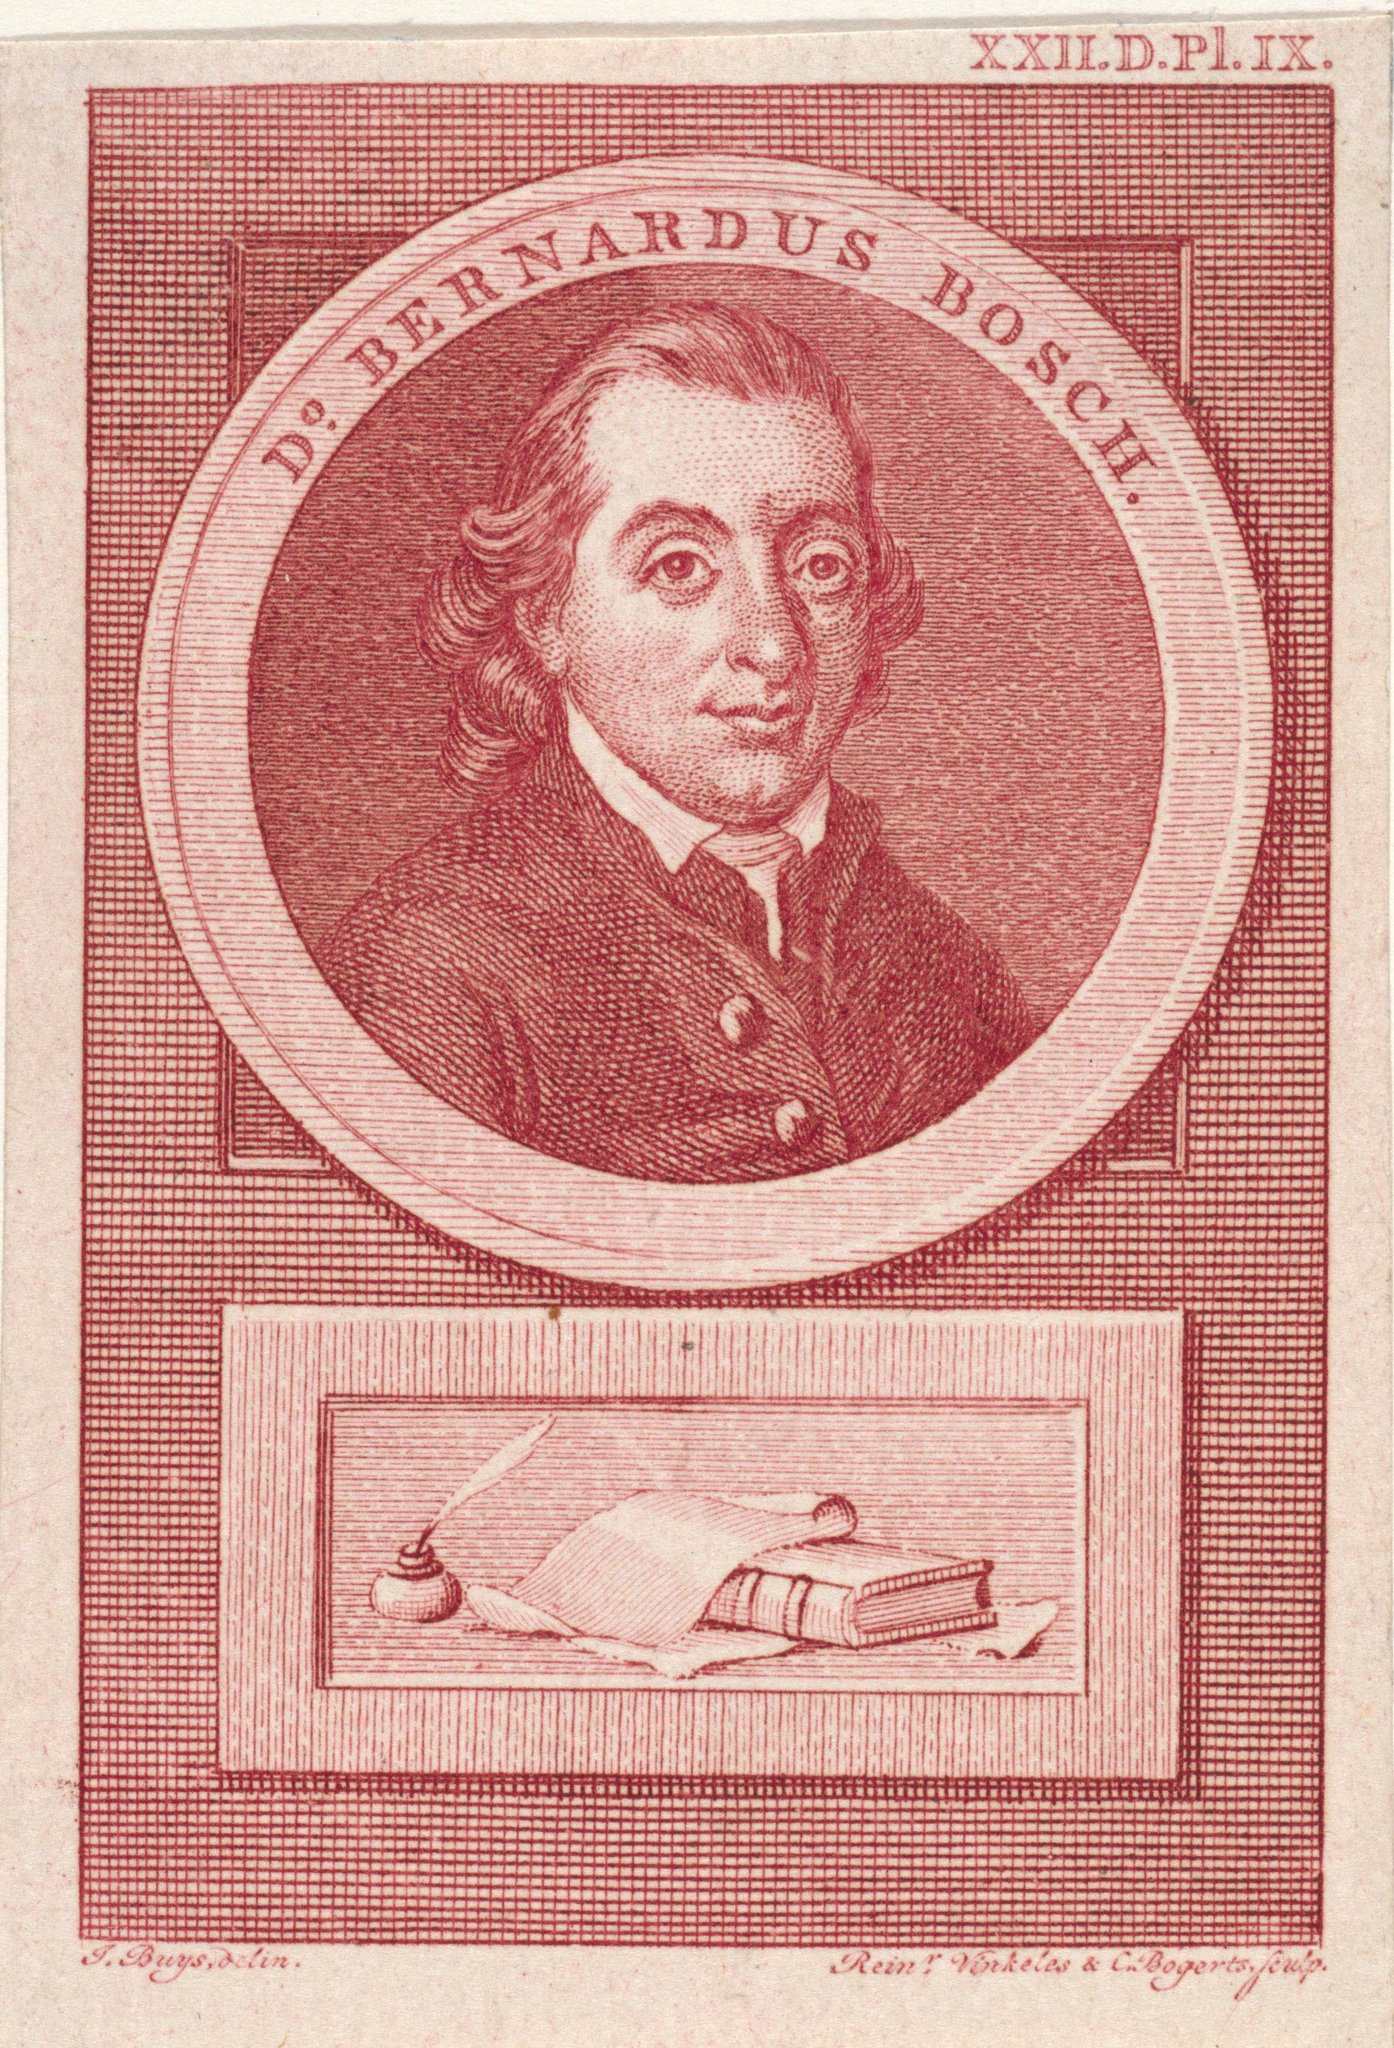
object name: print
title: Portret van Bernardus de Bosch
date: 1783-1795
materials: paper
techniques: engraving, etching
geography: amsterdam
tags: deventer, the hague, quill, ink-well, book, paper (writing material)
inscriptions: collector's mark: Lugt 2228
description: Portret van Bernardus de Bosch, dichter, predikant en representant in de Nationale Vergadering. Onder het portret een inktpot met schrijfveer, een boek en een vel papier. Rechtsboven: XXII.D.Pl.IX.